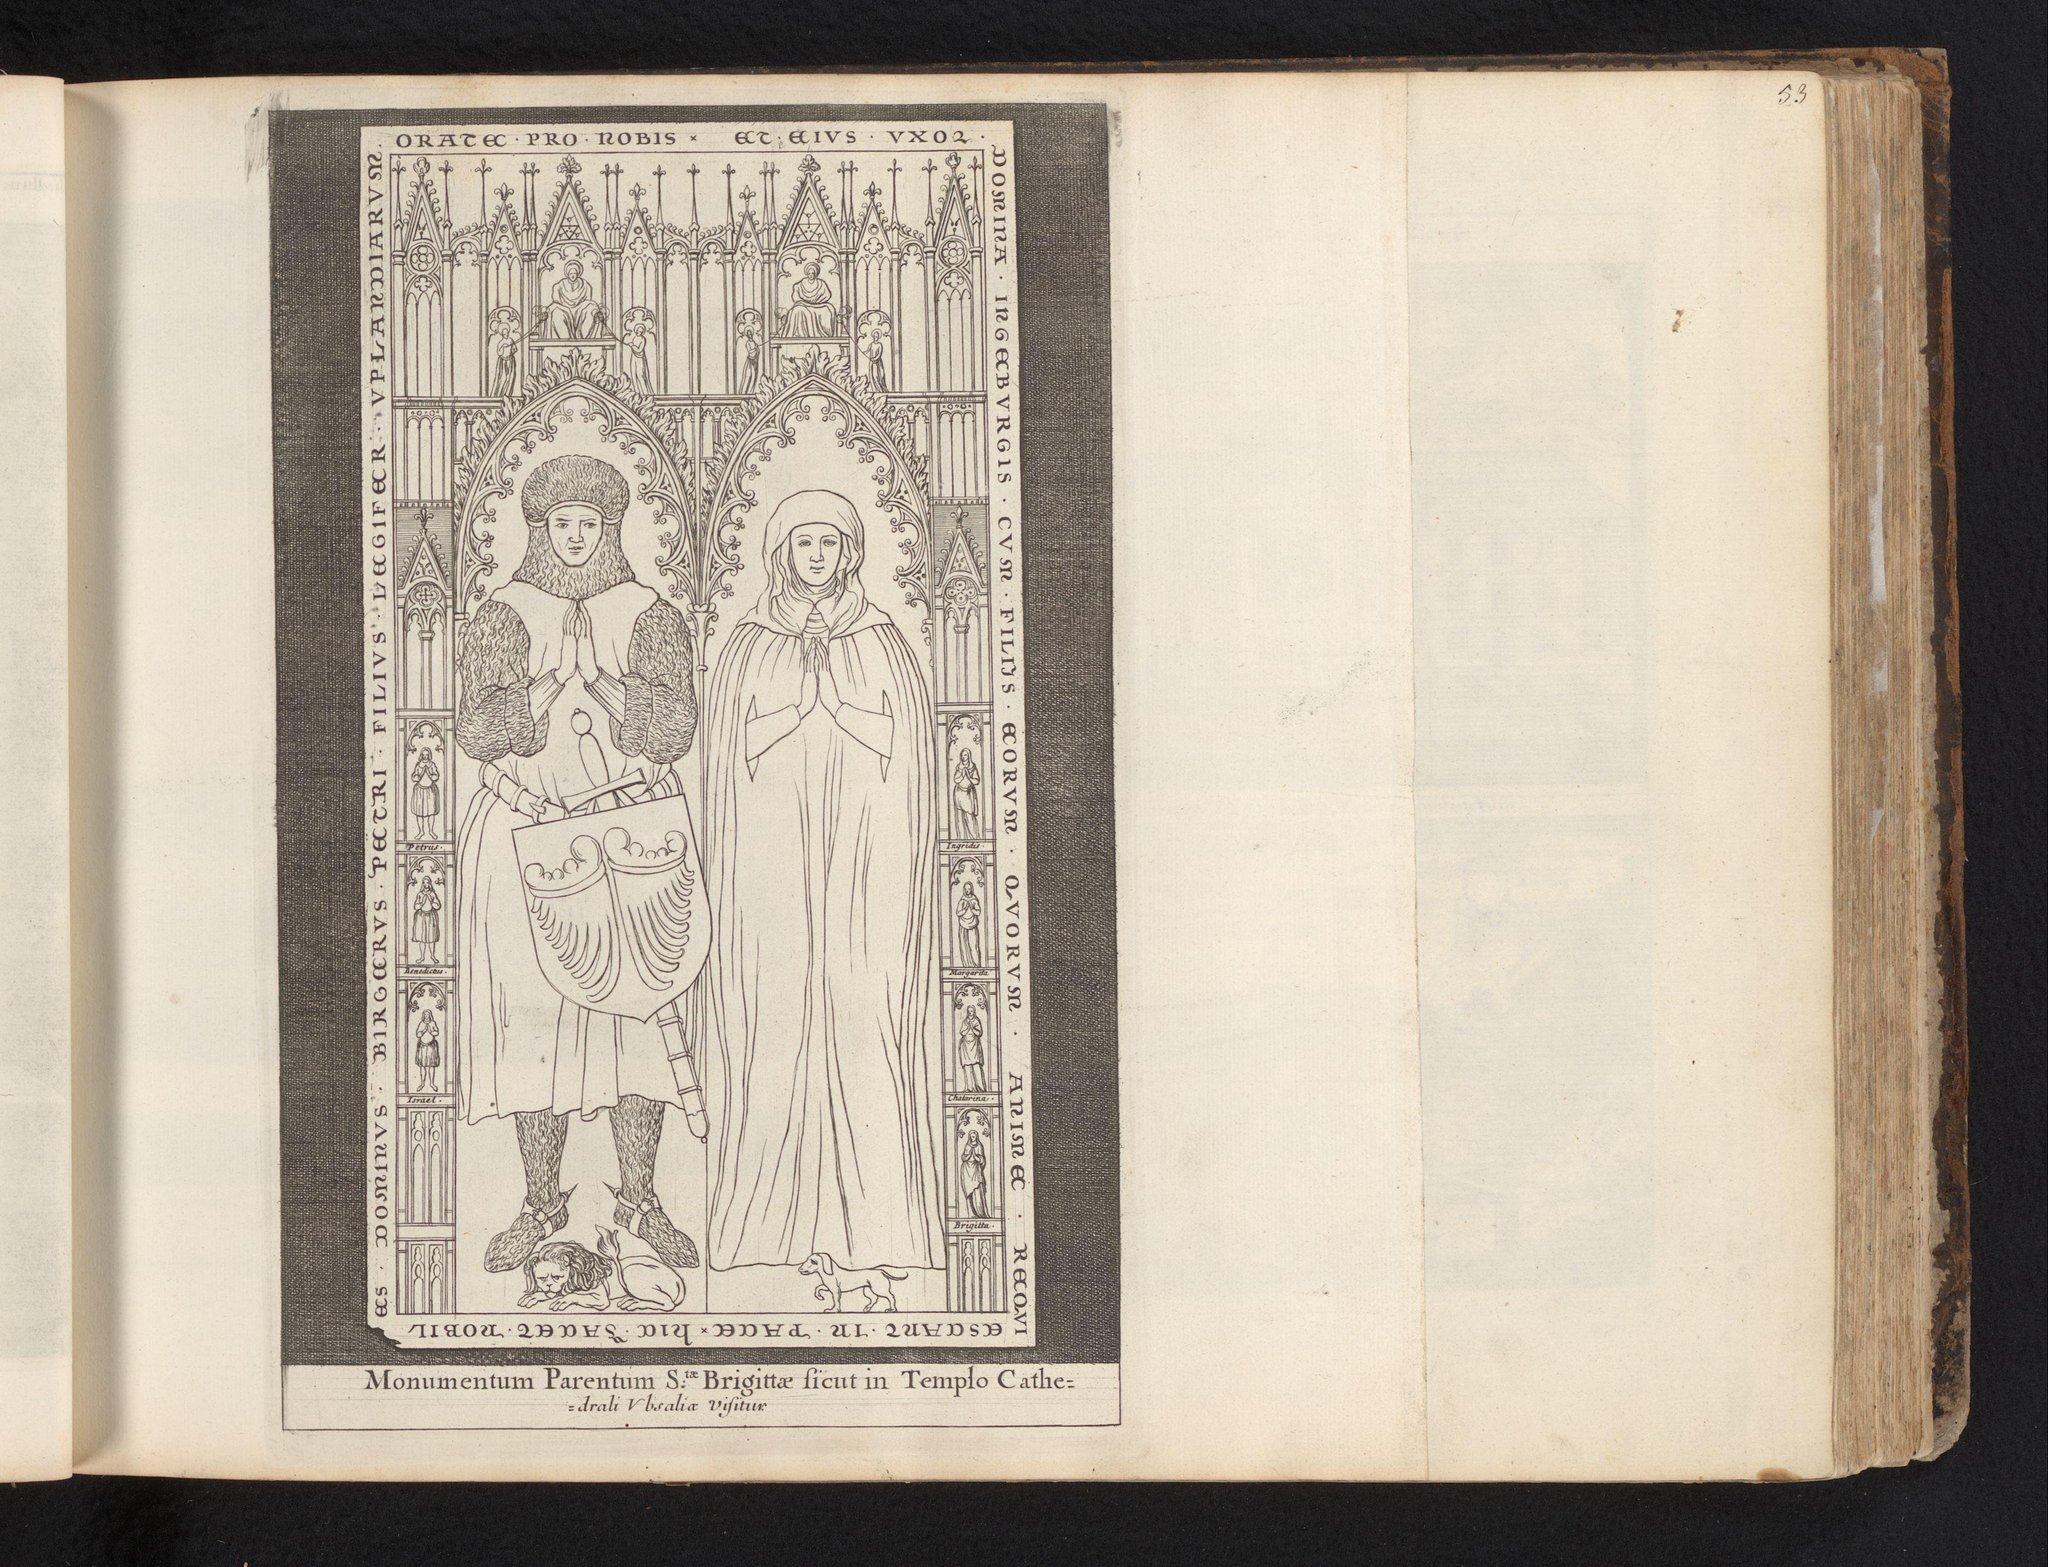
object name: album leaf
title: Monumentum Parentum S:tae Birgittae sicut in Templo Cathedrali Ubsaliae visitur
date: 1668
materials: paper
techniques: etching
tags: gravestone, tombstone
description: Kungliga Biblioteket, 'Suecia': http://www.kb.se/samlingarna/Kartor-bilder/Suecia-antiqua/ (geraadpleegd november 2016).